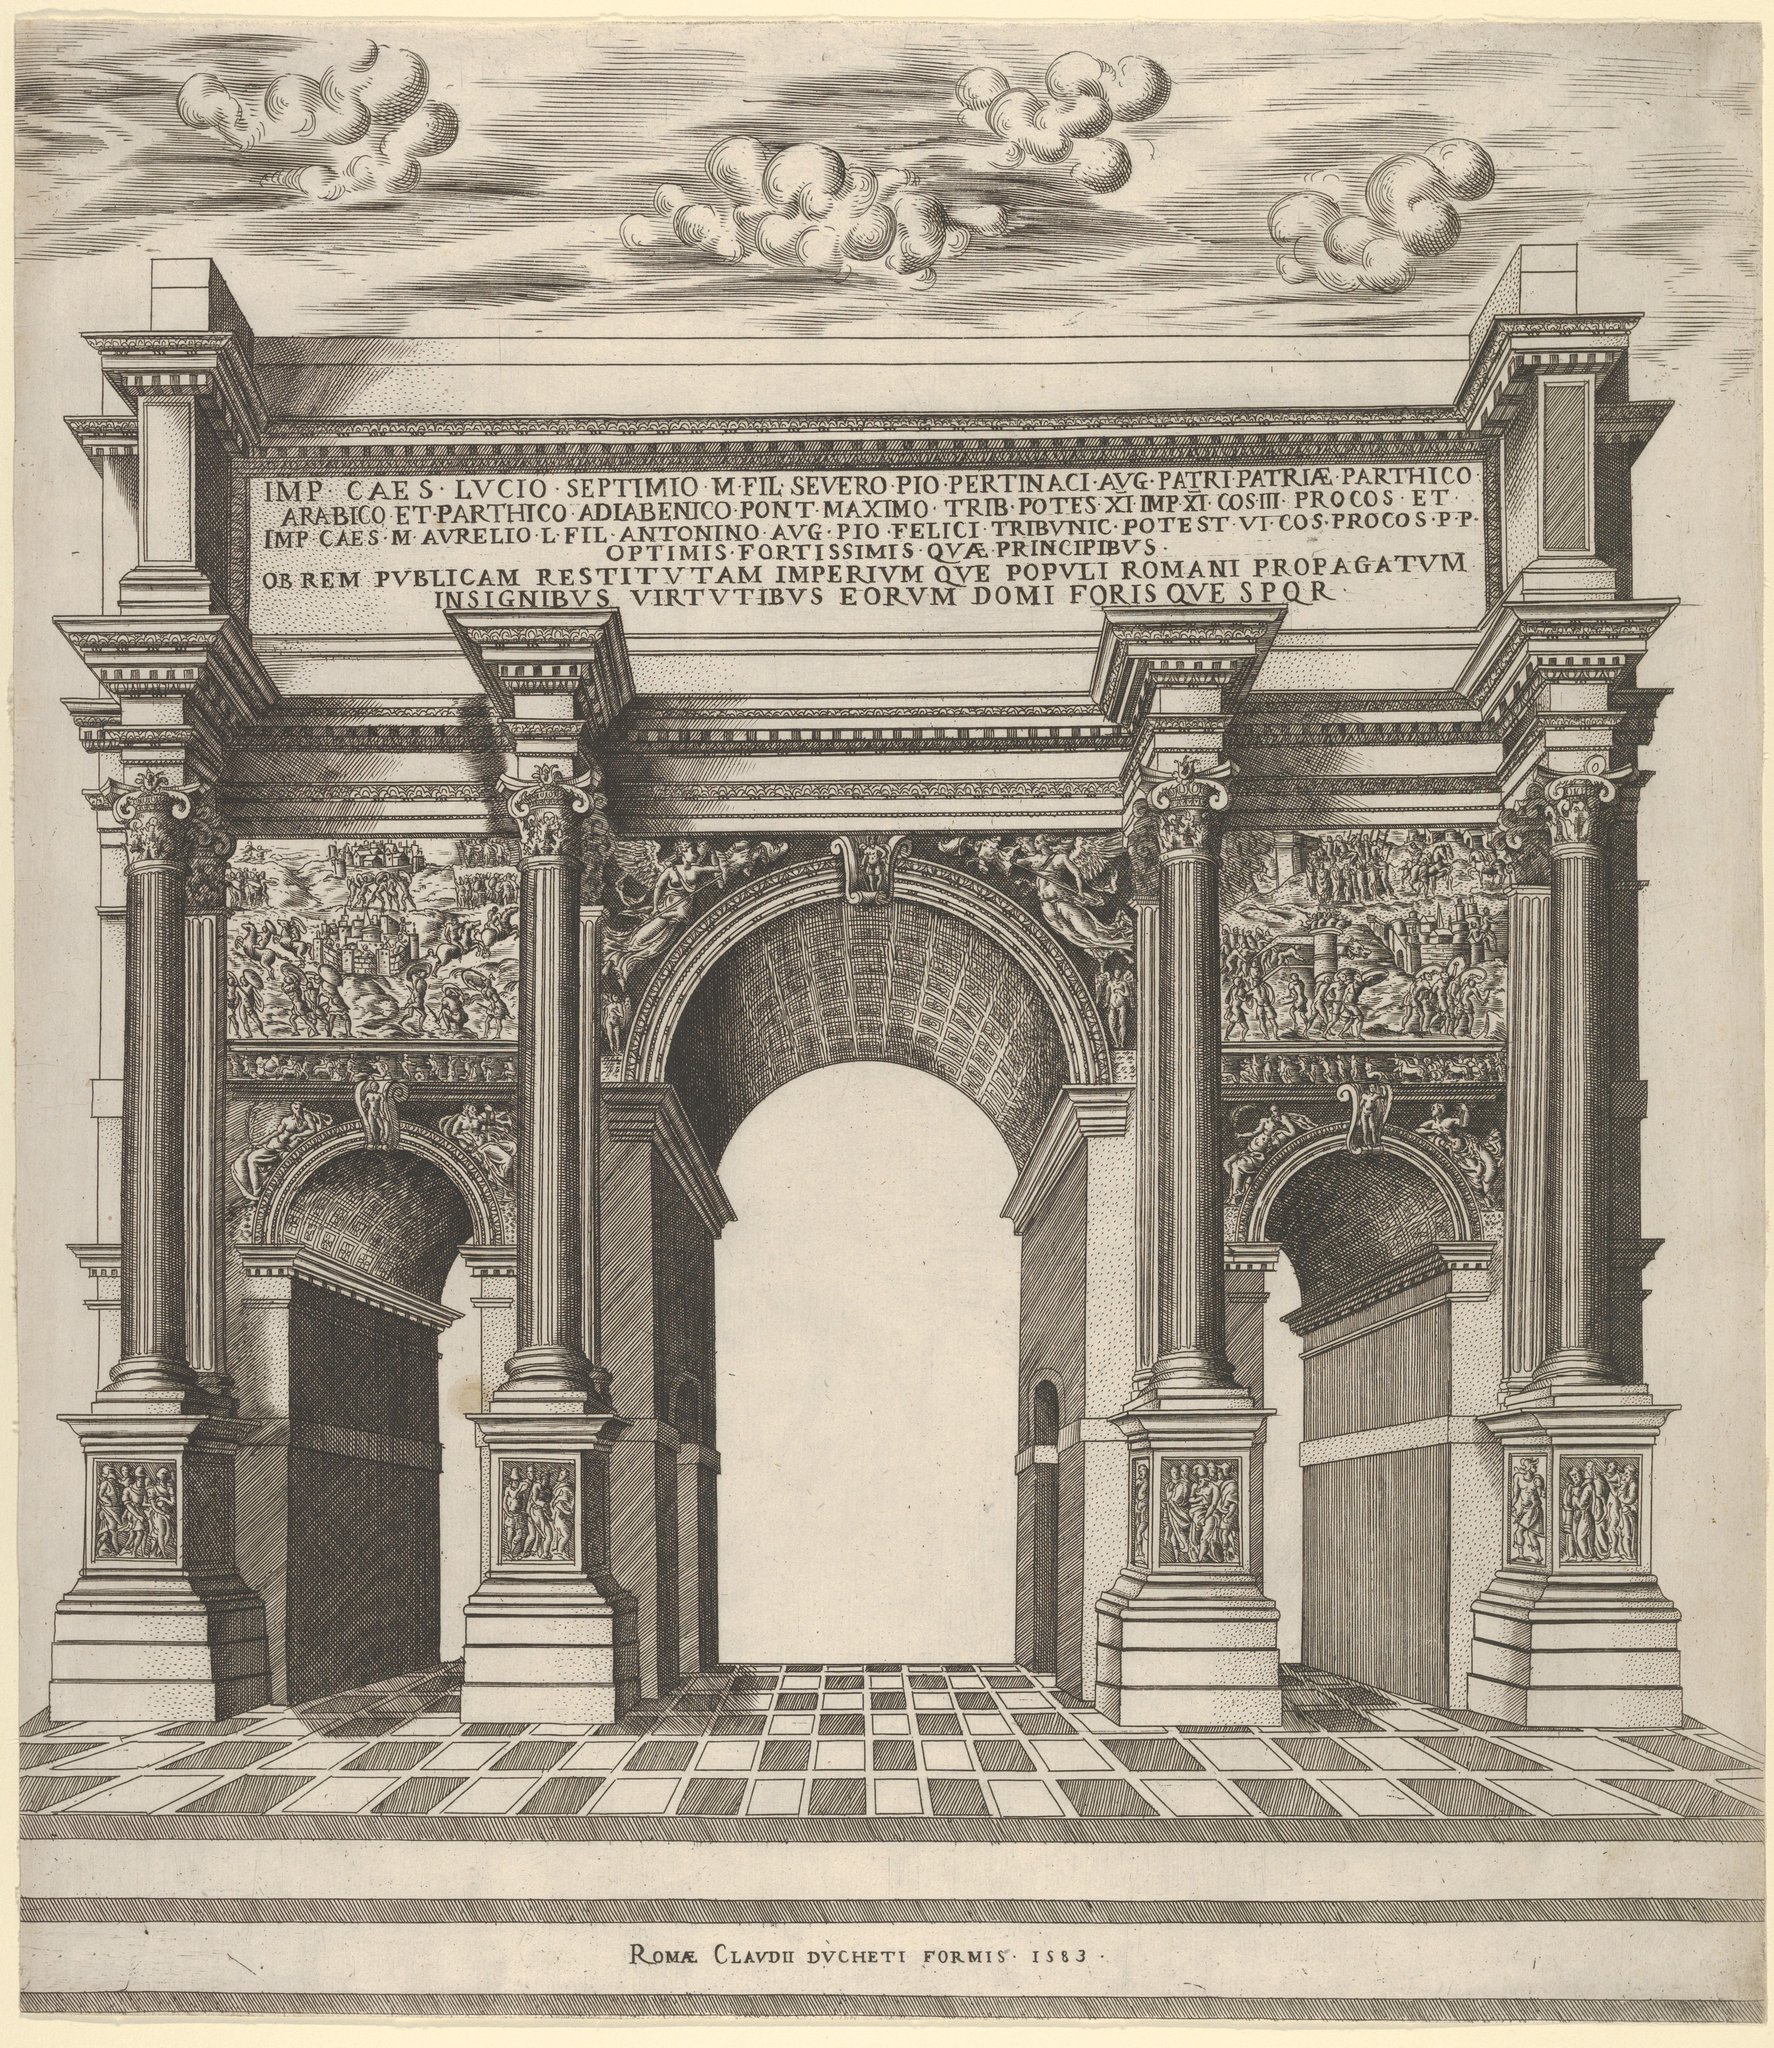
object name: print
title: Arch of Septimius Severus, from "Speculum Romanae Magnificentiae"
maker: anonymous, italian, 16th century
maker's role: artist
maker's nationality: italian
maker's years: 1500-1600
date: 1583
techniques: engraving, etching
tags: architecture,arches,rome